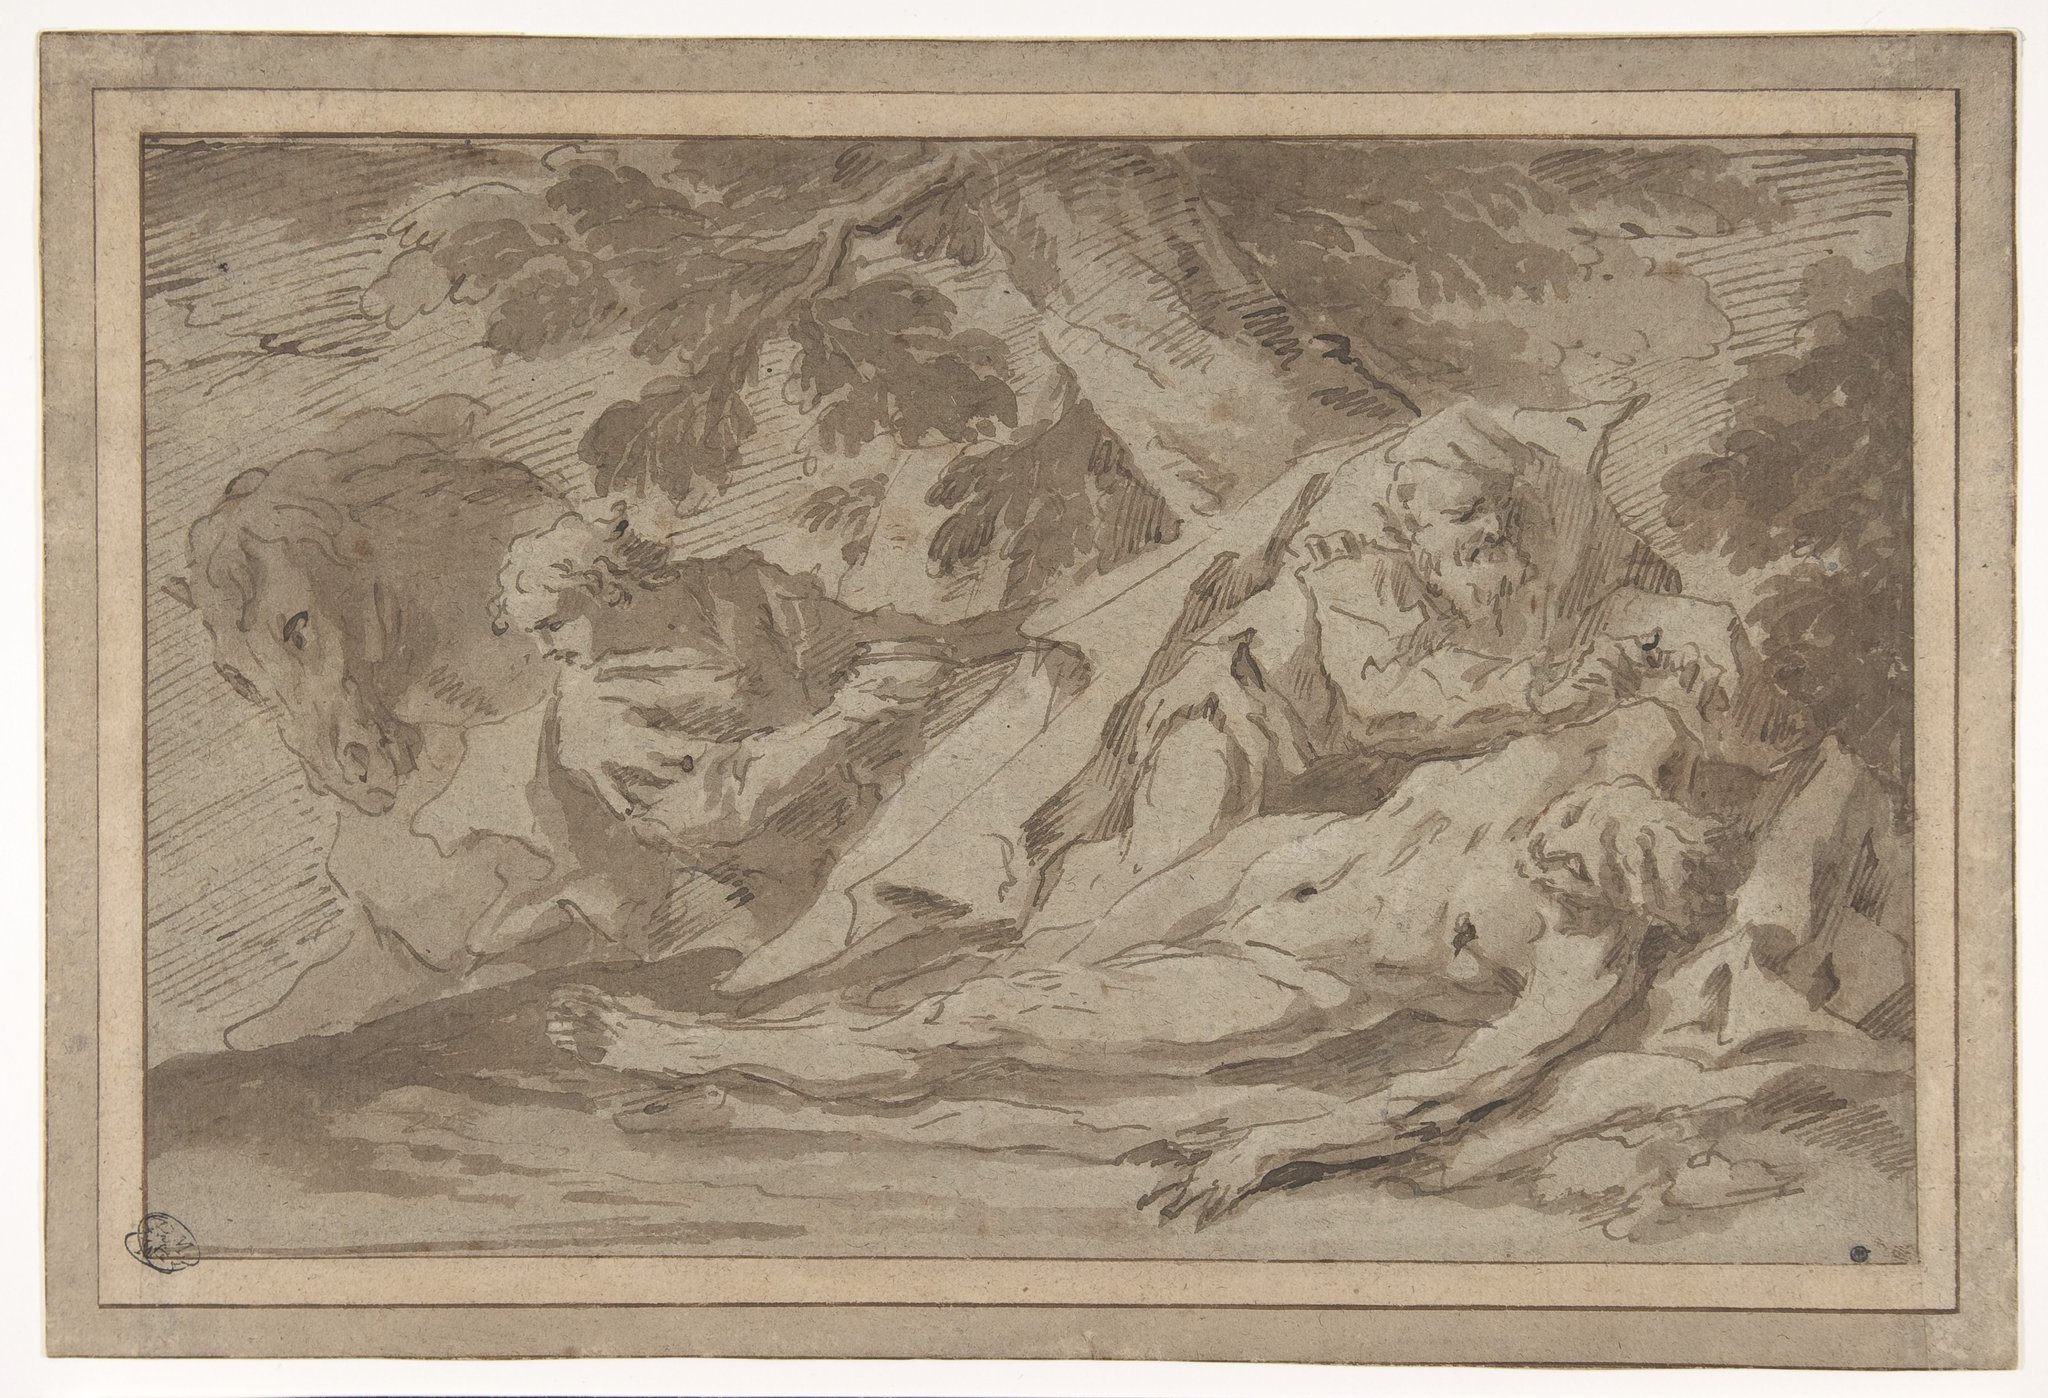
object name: drawing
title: The Good Samaritan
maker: gaspare diziani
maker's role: artist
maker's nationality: italian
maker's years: 1689-1767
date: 1689-1767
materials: ink, paper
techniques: brush, highlighting, pen, wash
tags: men,horses,trees